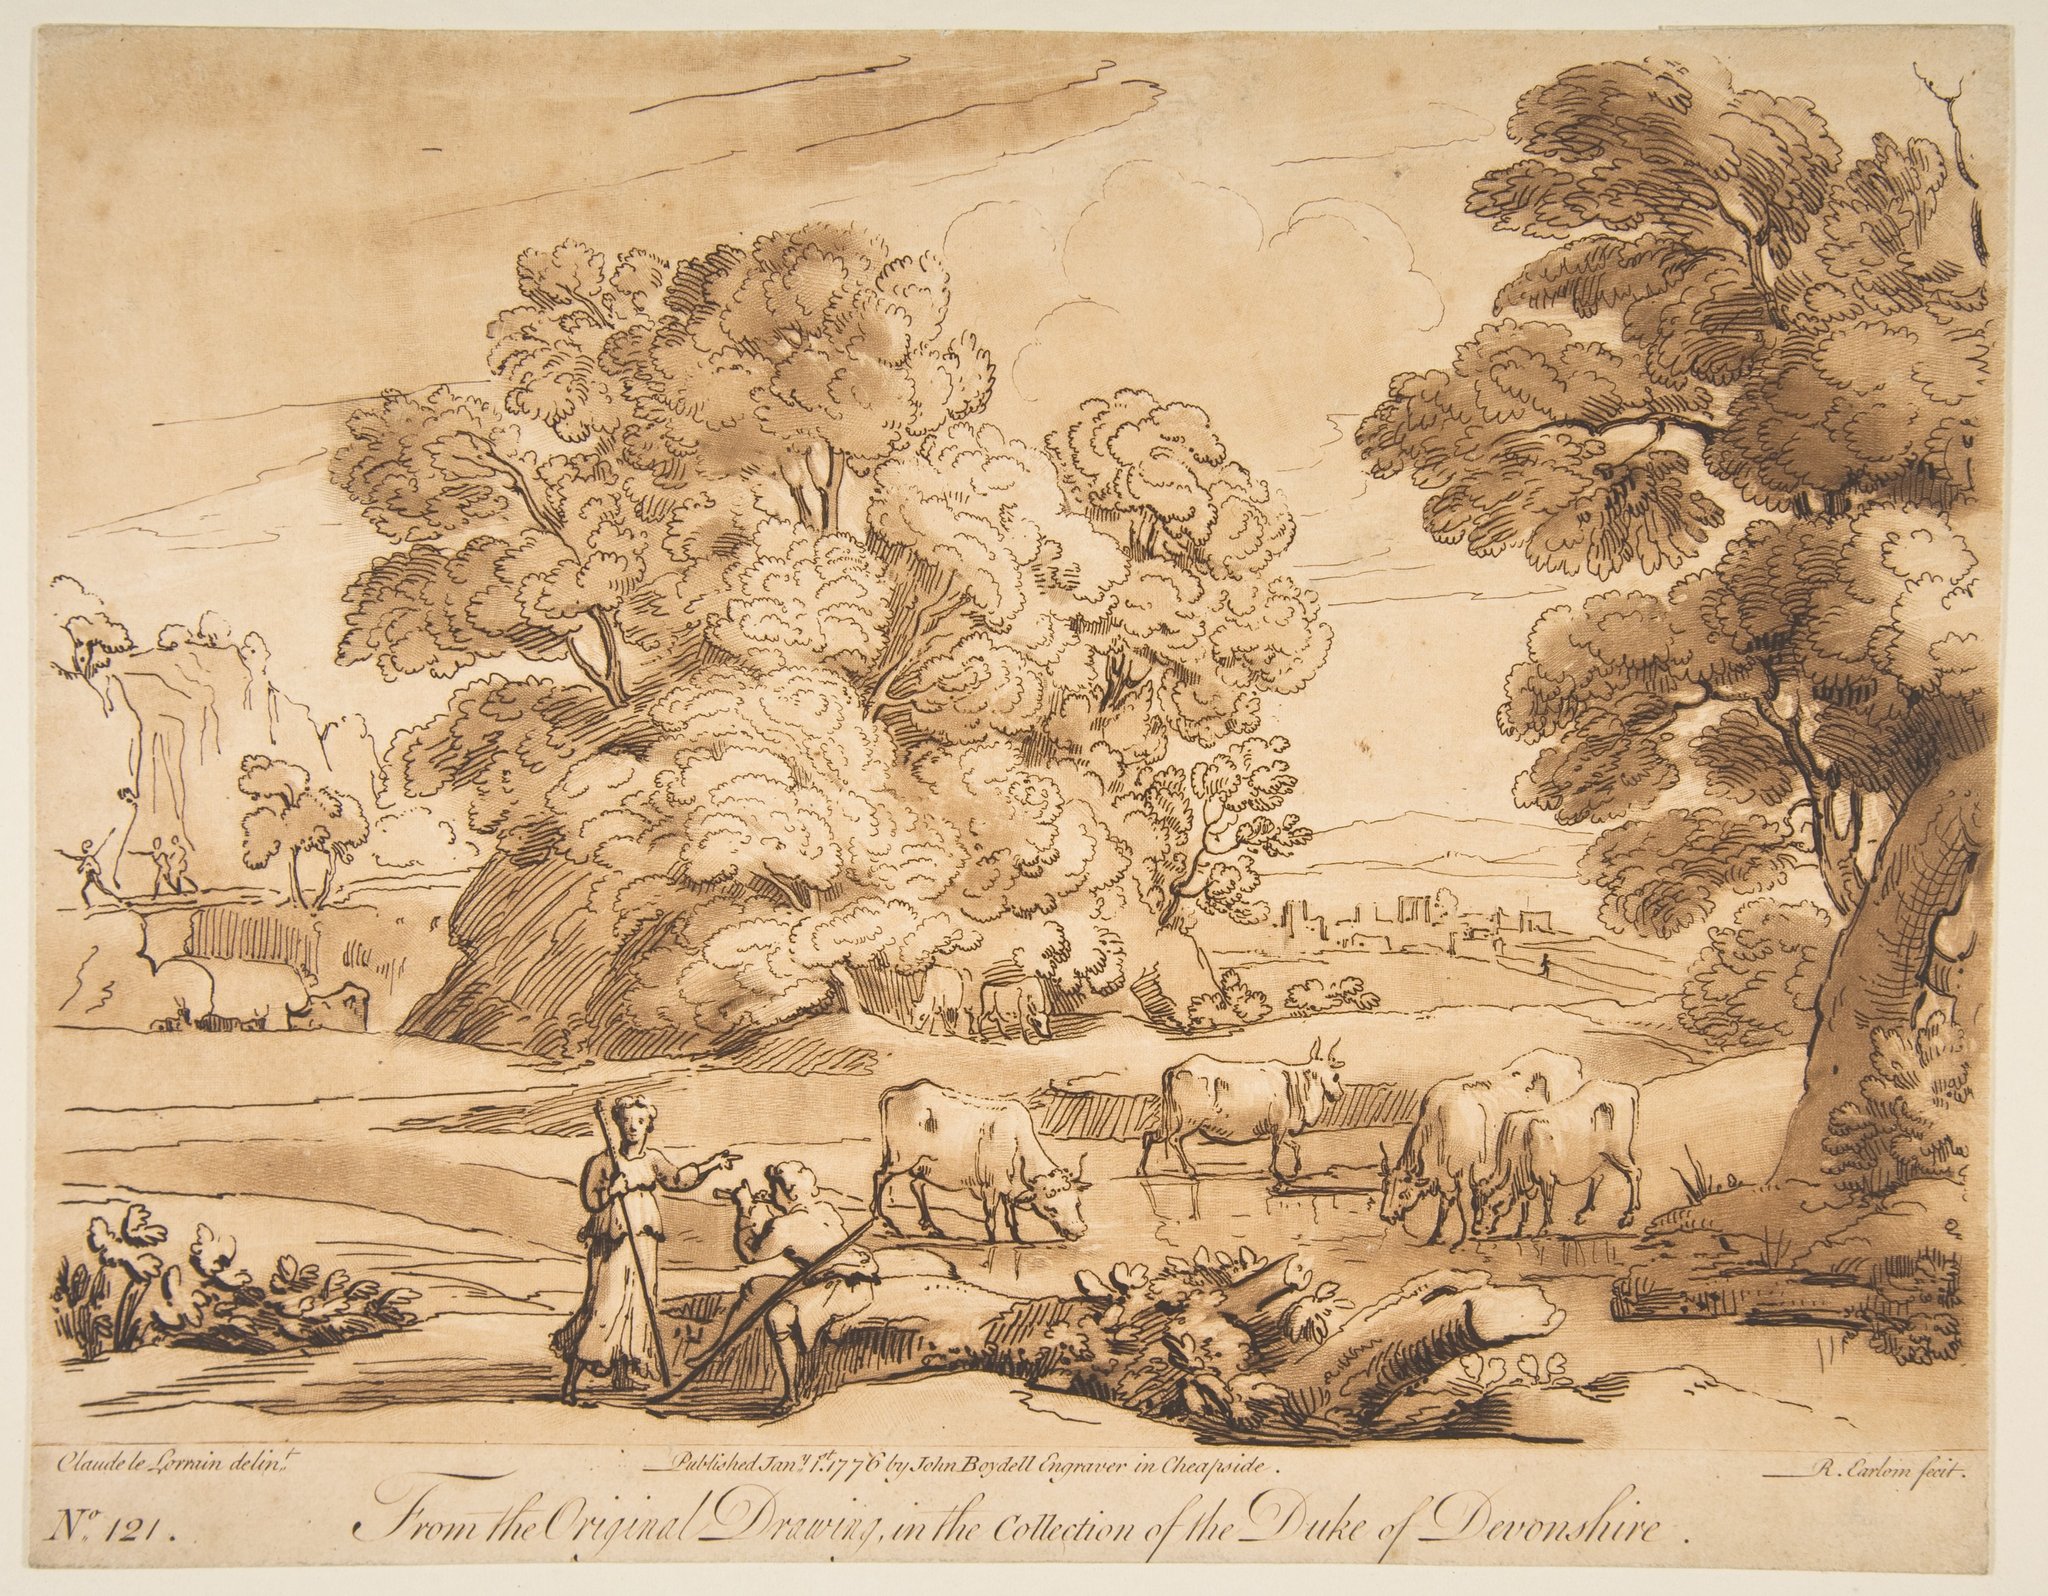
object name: print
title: Landscape with Shepherd and Shepherdess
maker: richard earlom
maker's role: engraver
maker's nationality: british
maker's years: 1743-1822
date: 1776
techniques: etching, mezzotint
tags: human figures,cows,landscapes,trees,shepherds